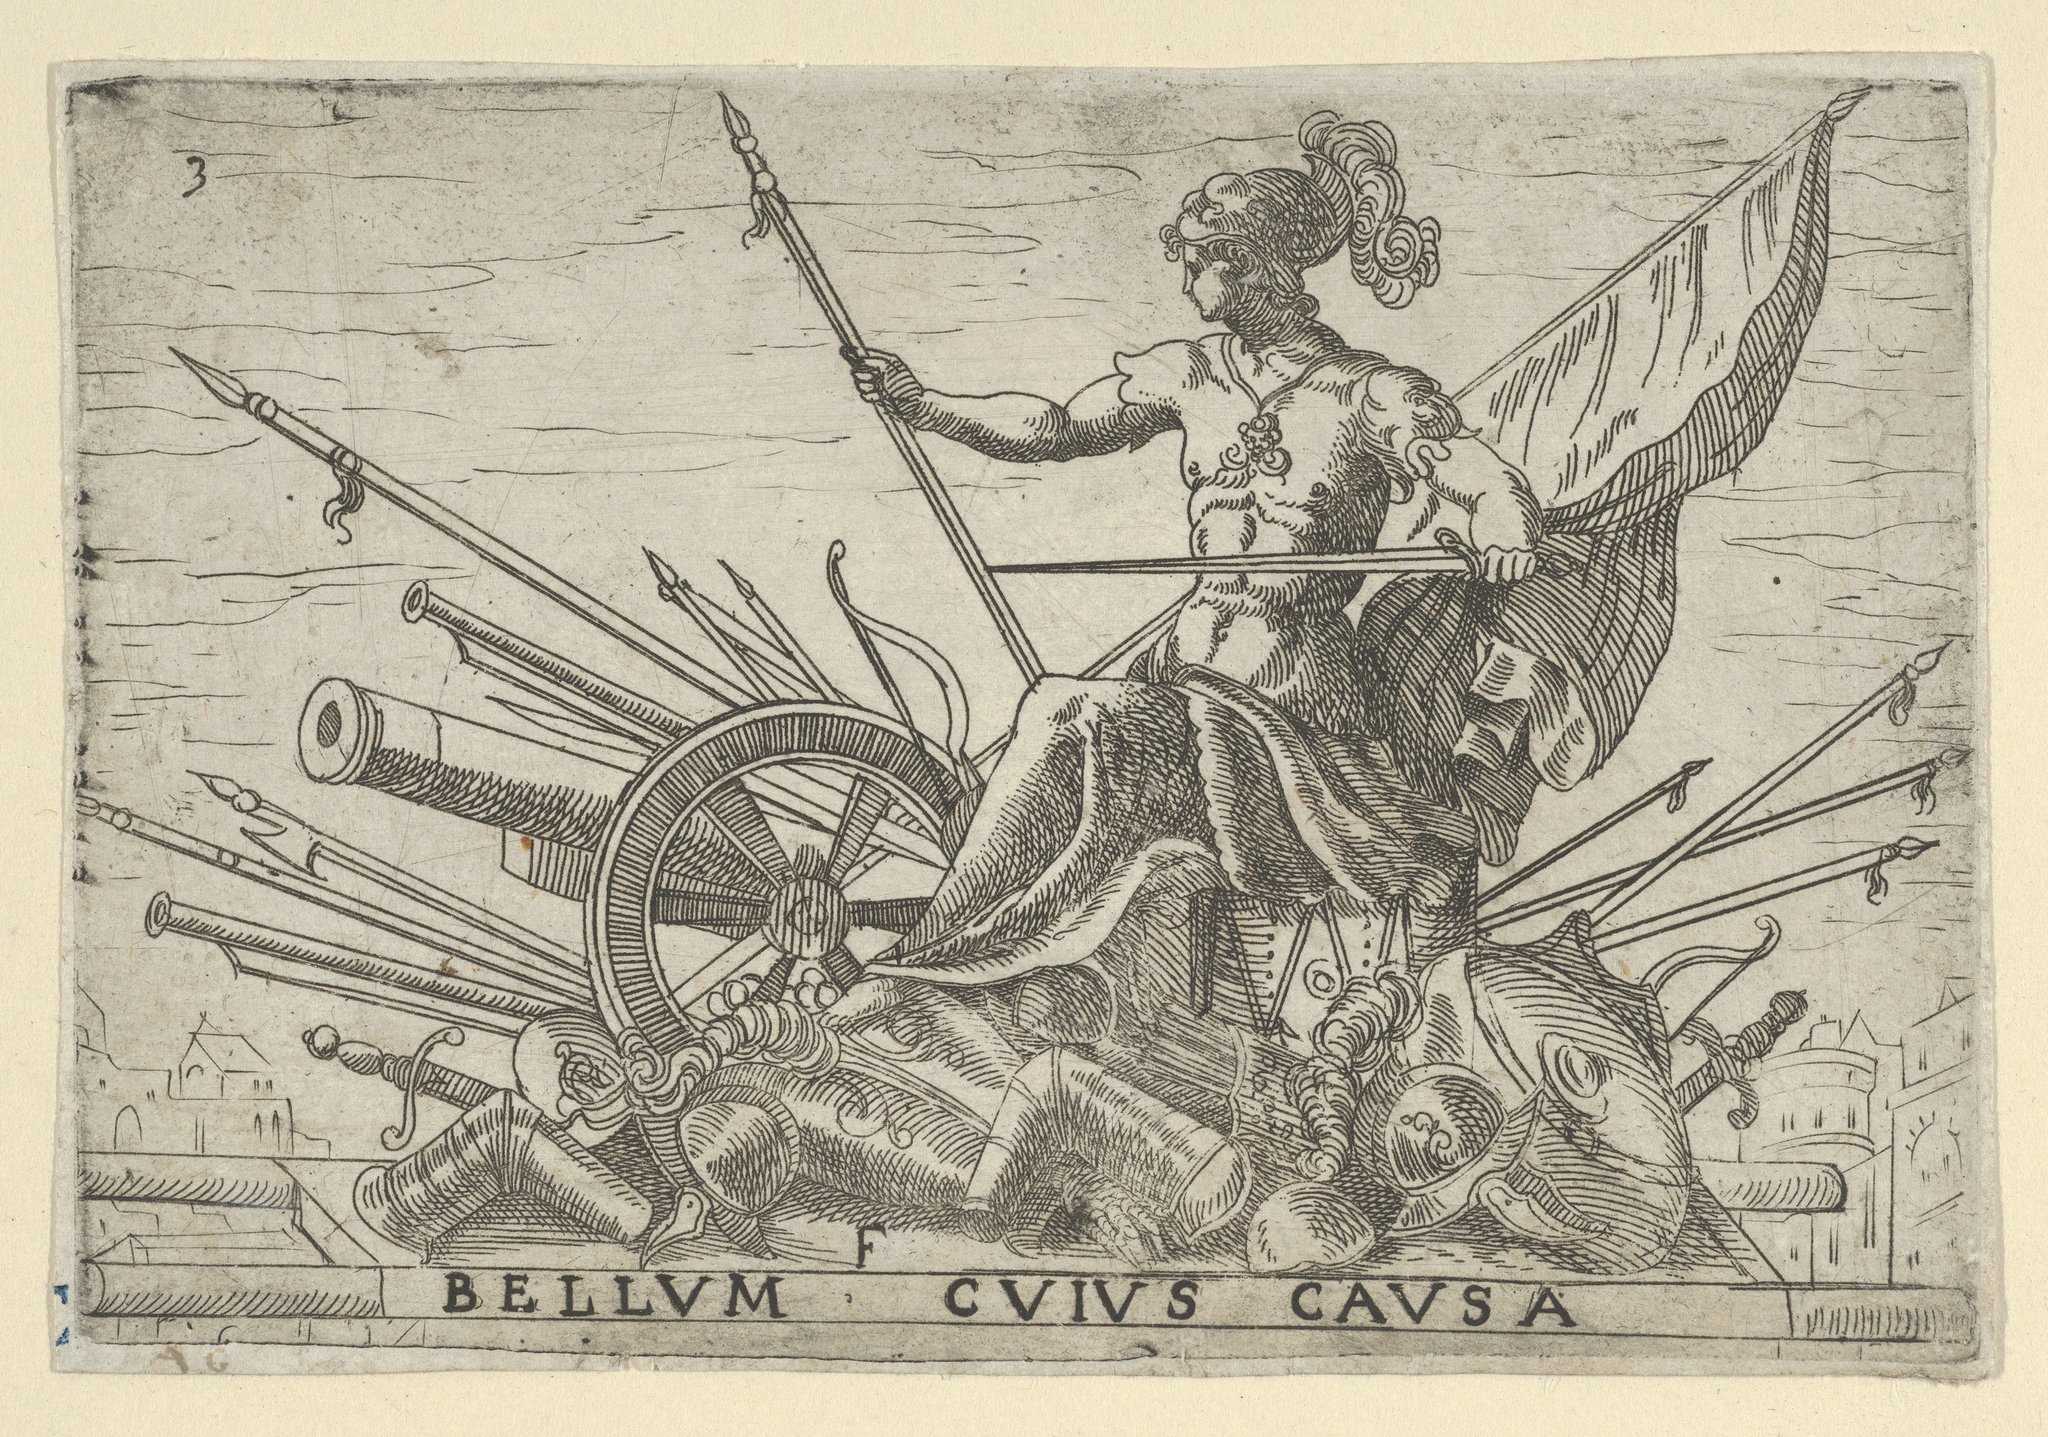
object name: print, fete, ornament architecture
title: Bellum Cuius Causa (The Cause of War)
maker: anonymous, italian, 16th century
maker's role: artist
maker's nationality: italian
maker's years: 1500-1600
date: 1501-1600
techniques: etching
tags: cannons,spears,swords,men,flags